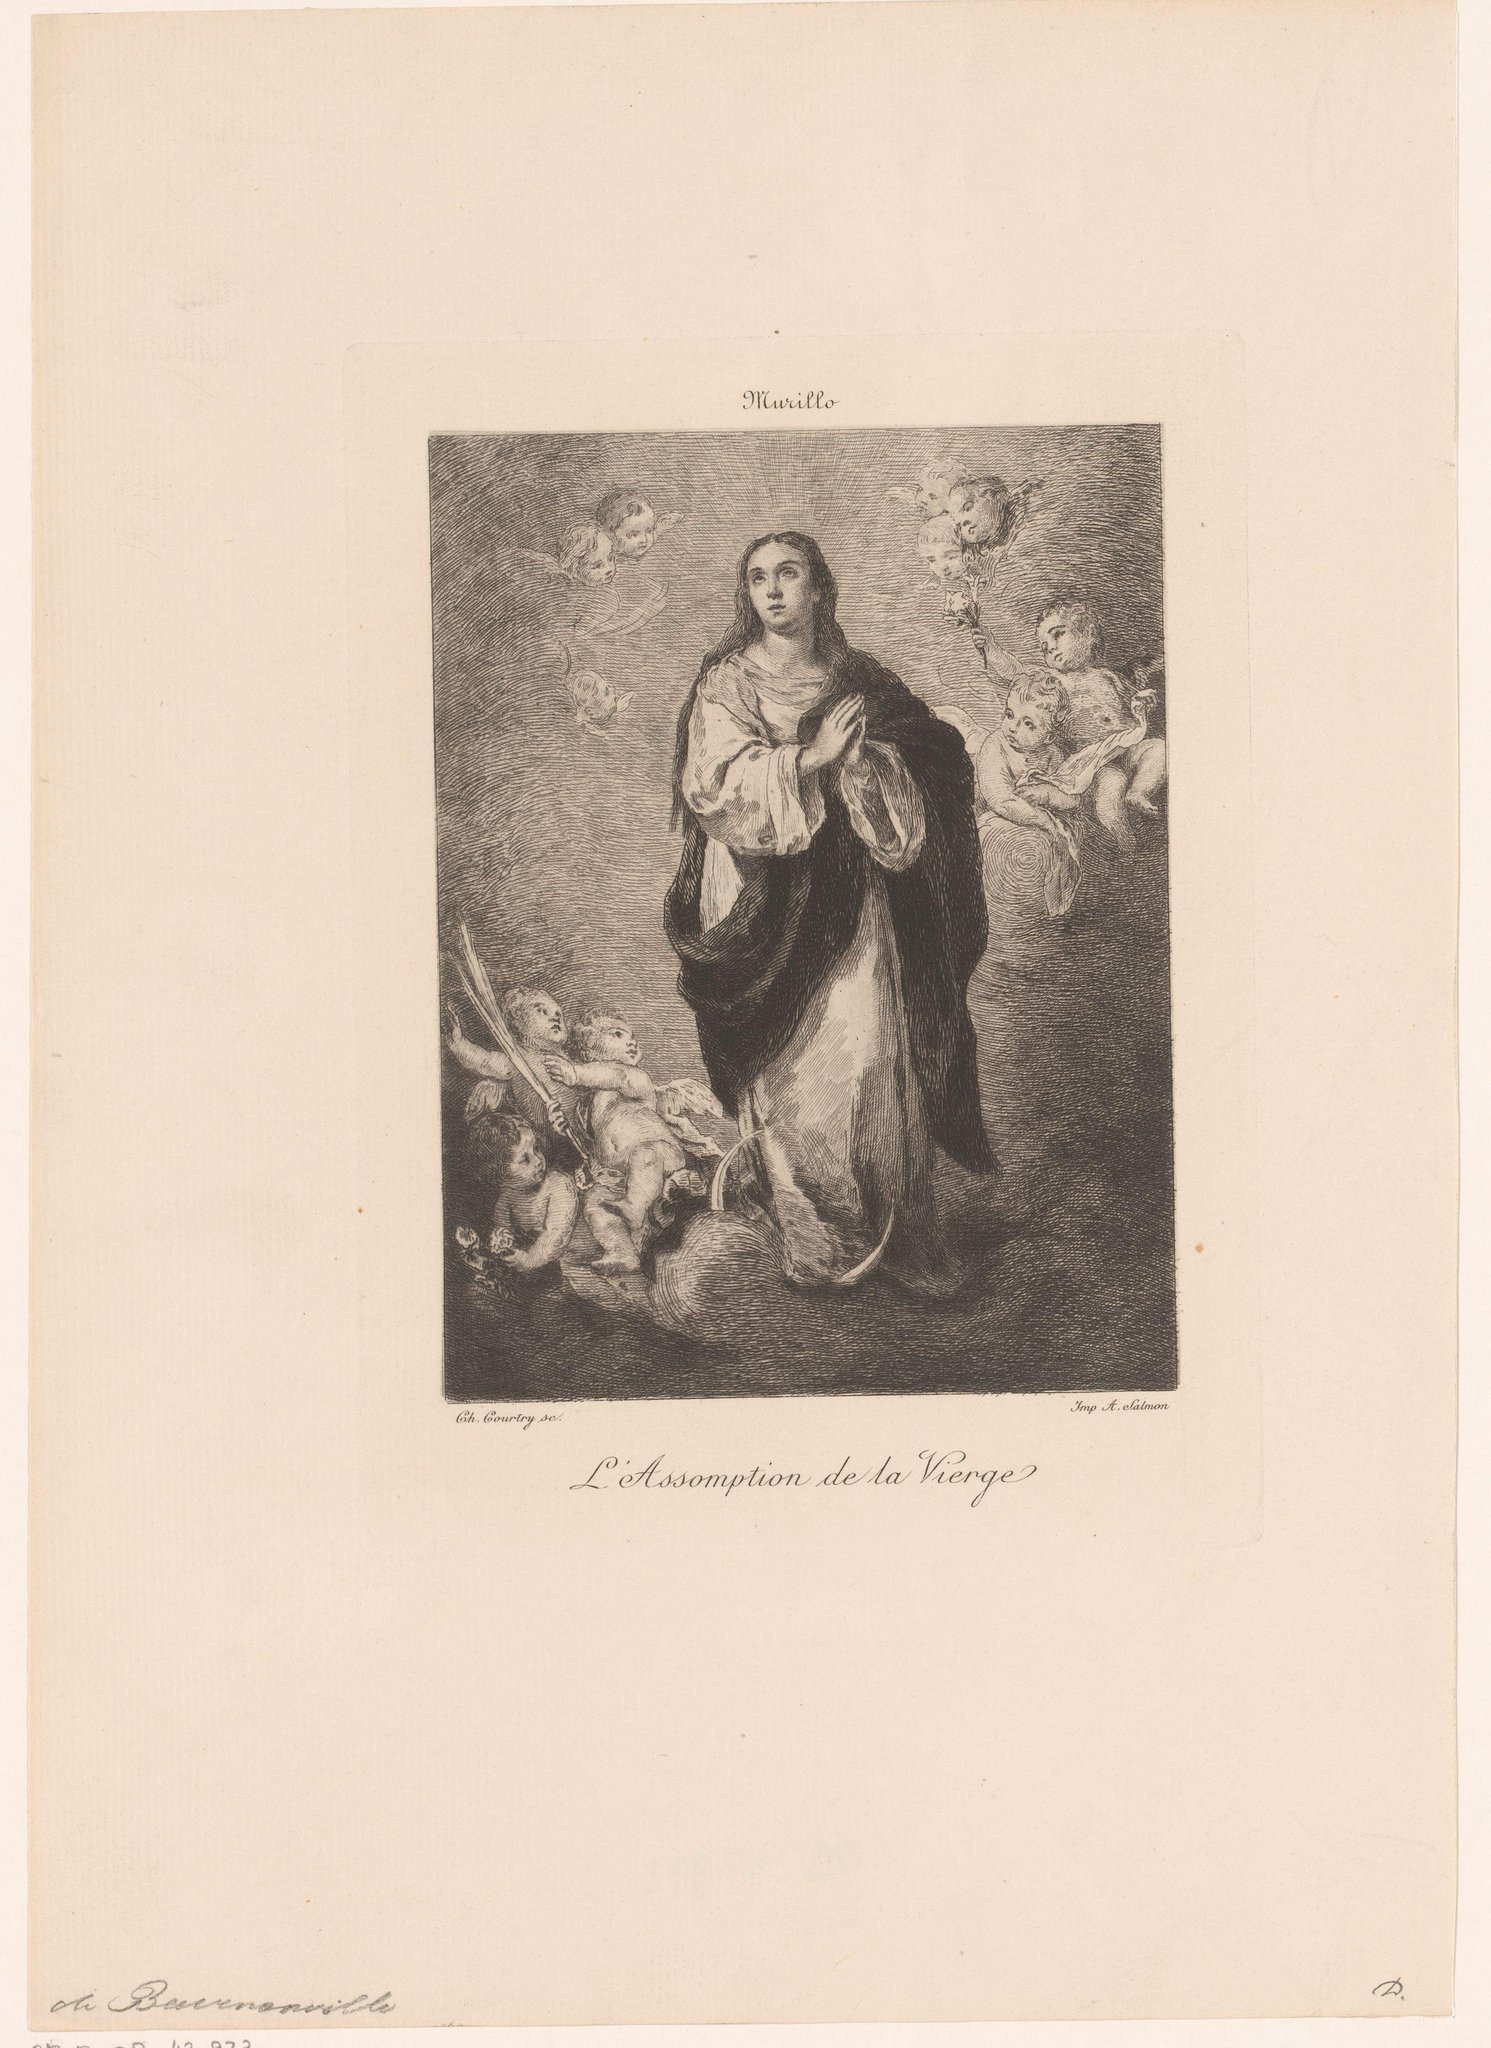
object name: print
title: L'Assomption de la Vierge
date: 1881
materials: paper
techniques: etching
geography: paris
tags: the assumption of mary ('assumptio corporis'): she is borne into heaven by angels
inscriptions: collector's mark: Lugt 2228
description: Prent afkomstig uit een veilingcatalogus: "Catalogue des Tableaux anciens composant la très importante collection de Monsieur le Baron de Beurnonville", uitgegeven in 1881 te Parijs door Pillet en Dumoulin. De veiling vond plaats van 9 tot en met 14 en 16 mei 1881.